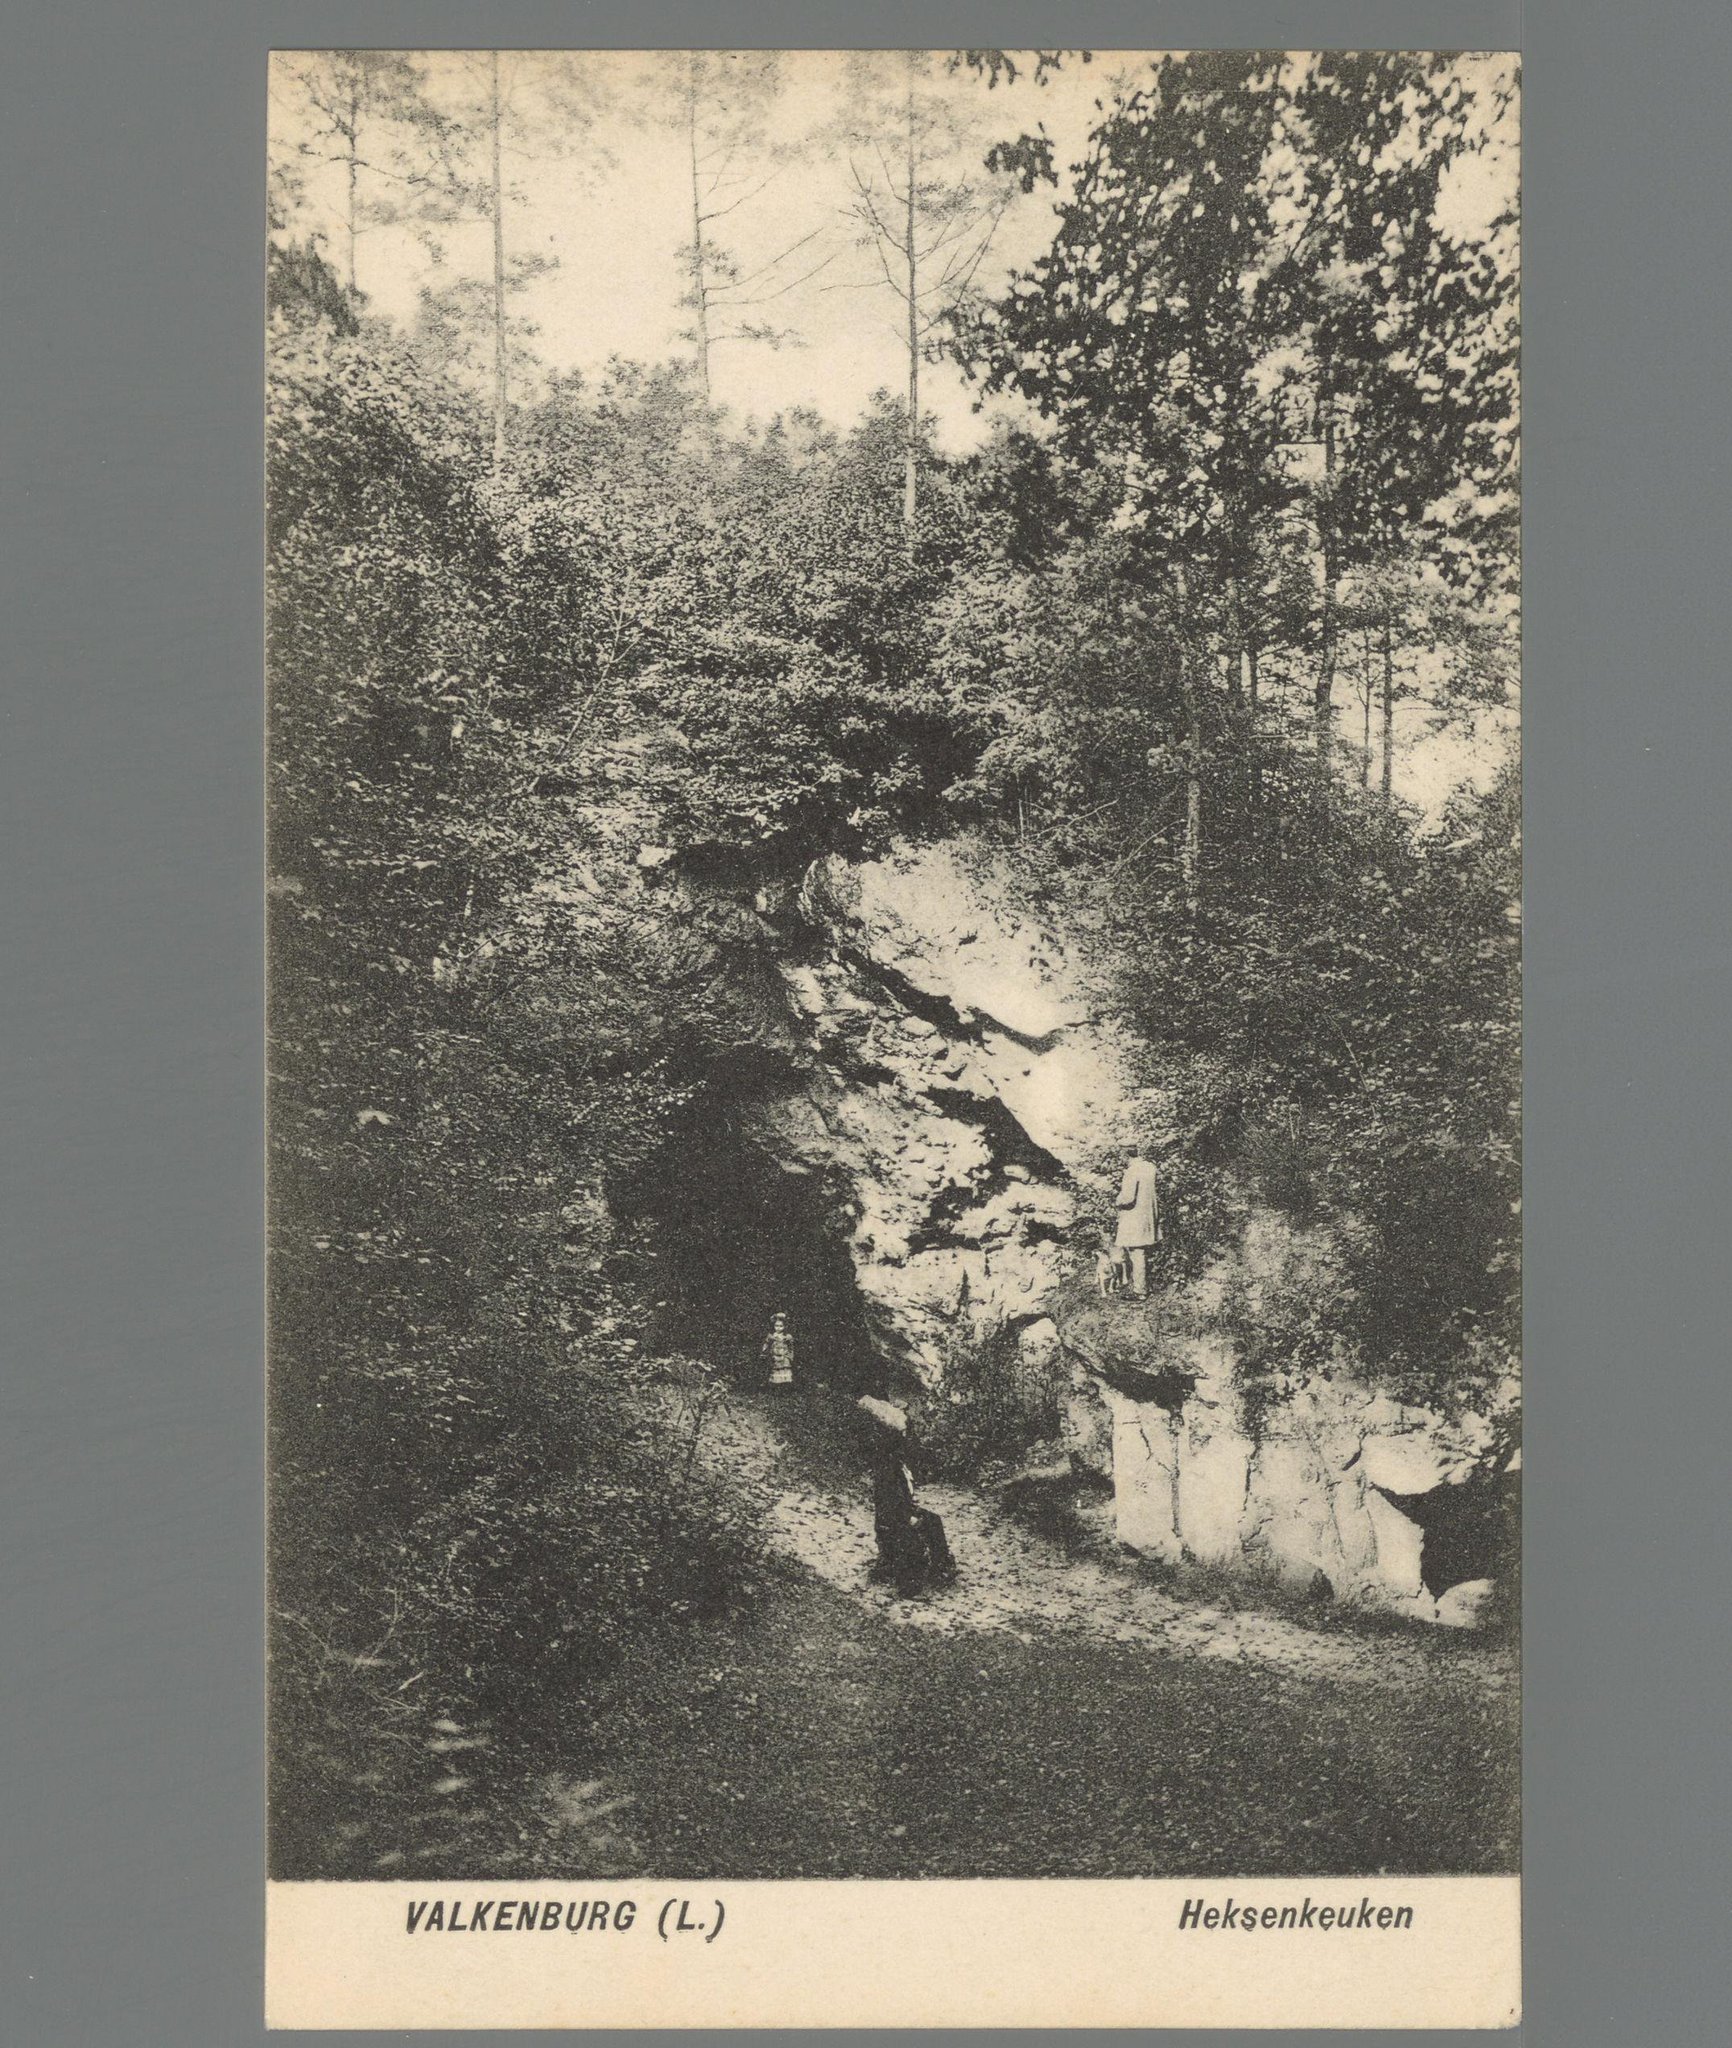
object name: photomechanical print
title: Valkenburg (L.). Heksenkeuken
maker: Anonymous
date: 1905-1908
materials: cardboard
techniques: photograph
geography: valkenburg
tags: cave, grotto, rocks